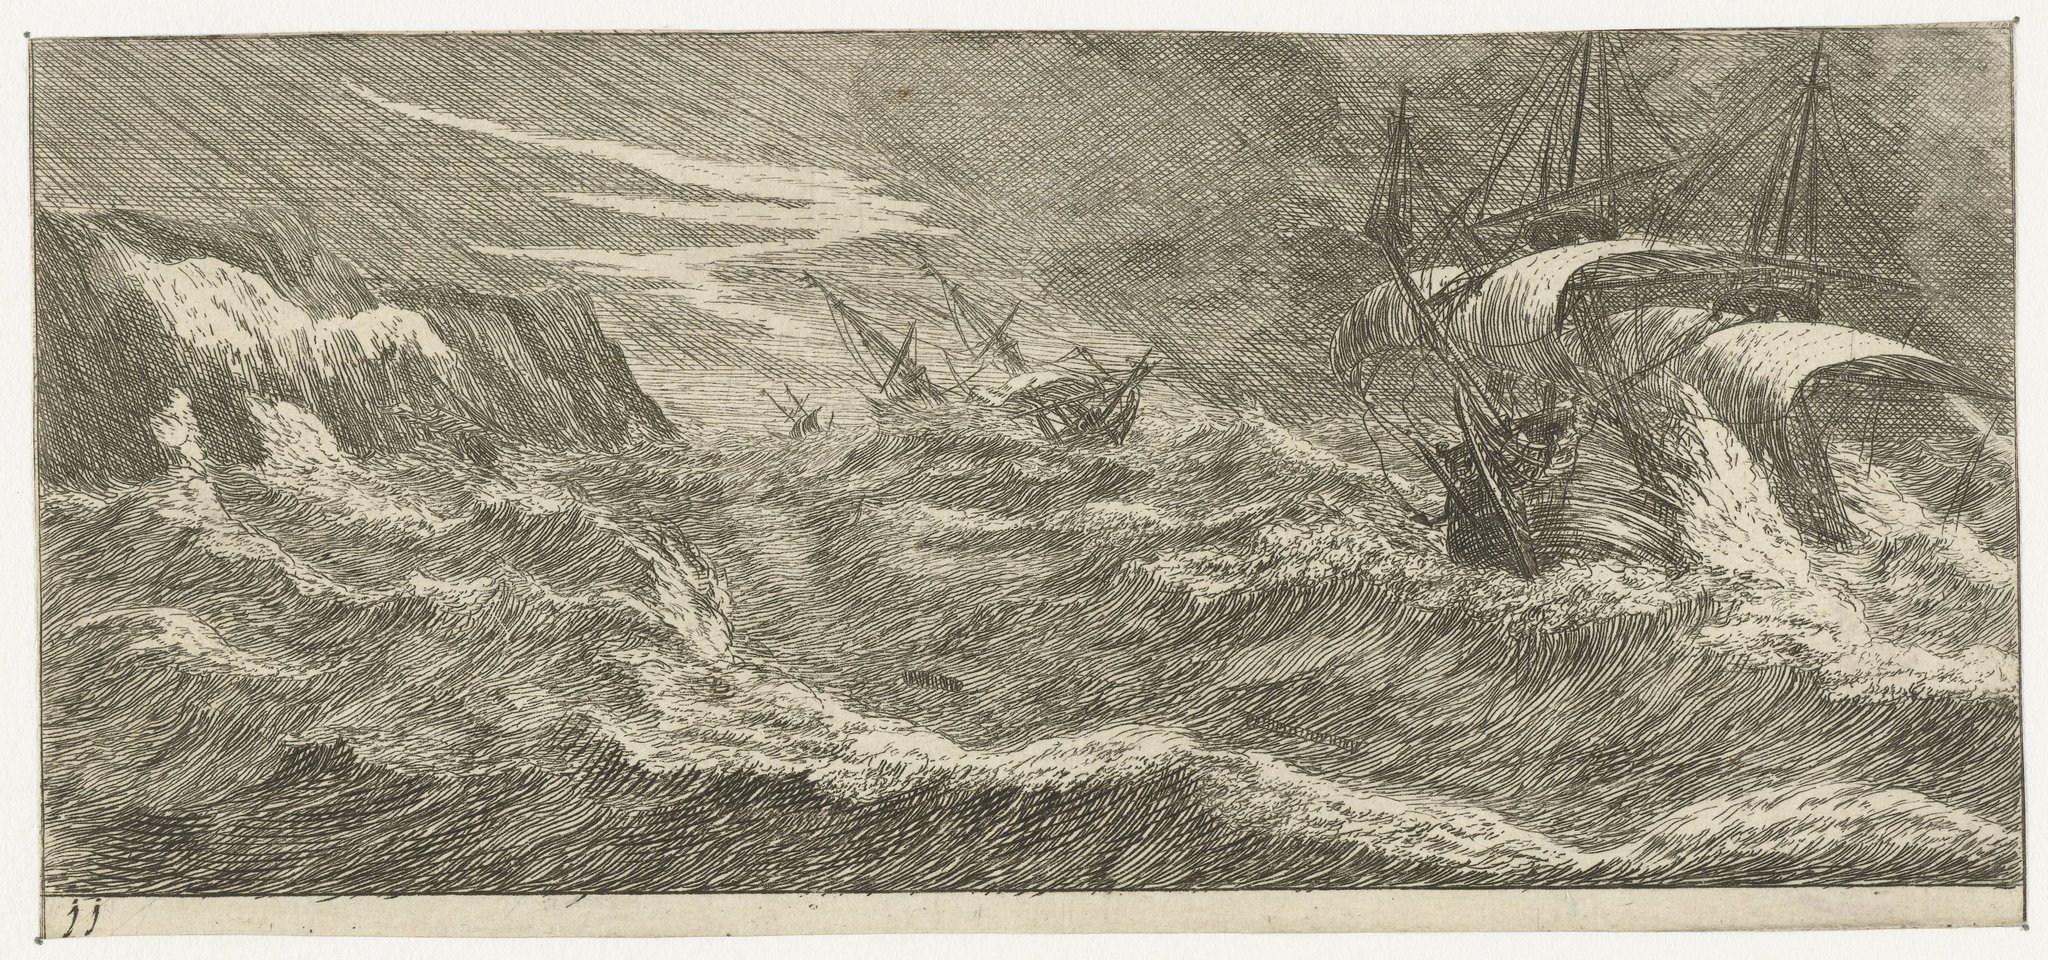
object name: print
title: Zeilschepen in een zeestorm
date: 1651-1652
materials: paper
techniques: engraving, etching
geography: netherlands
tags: sailing-ship, sailing-boat, storm at sea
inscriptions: collector's mark: Lugt 12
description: Drie zeilschepen op een zeer ruige zee tijdens een storm, vlak bij een rotsachtige kust.